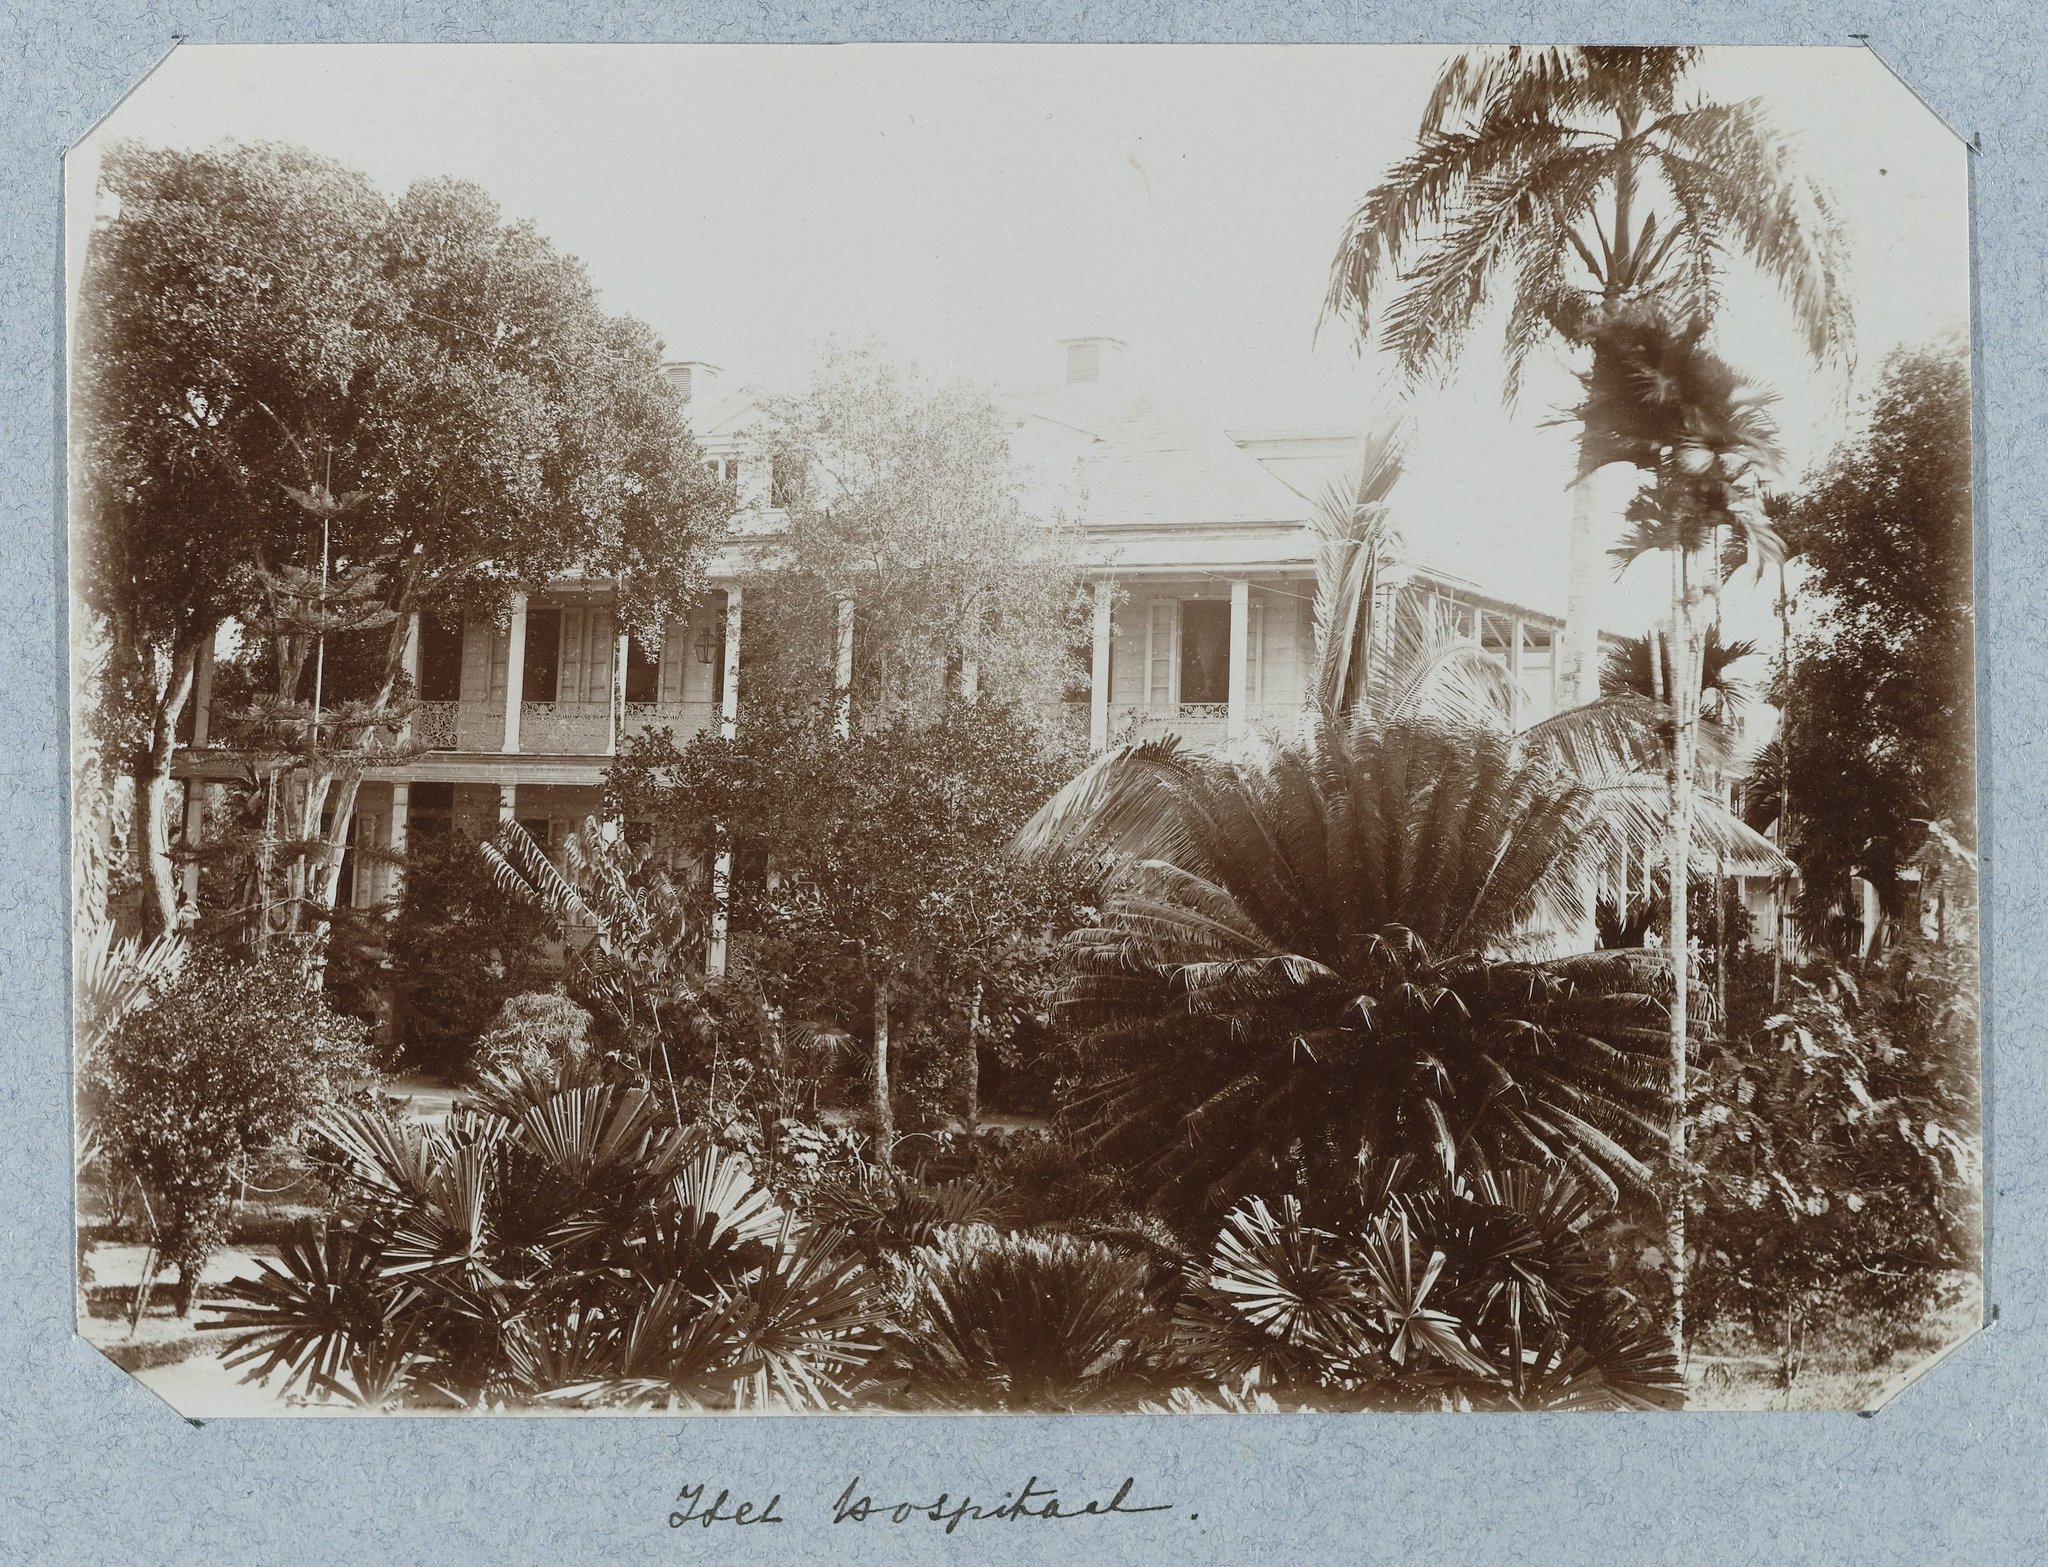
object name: photograph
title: Het hospitaal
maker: théodore van lelyveld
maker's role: painter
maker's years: 1867-1954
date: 1895-1898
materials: photographic support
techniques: collodion silver print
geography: suriname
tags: hospital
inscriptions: inscription: ‘Het hospitaal’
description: Het hospitaal te Paramaribo. Fotoafdruk in een fotoalbum van Théodore van Lelyveld over Suriname uit 1895-1898.